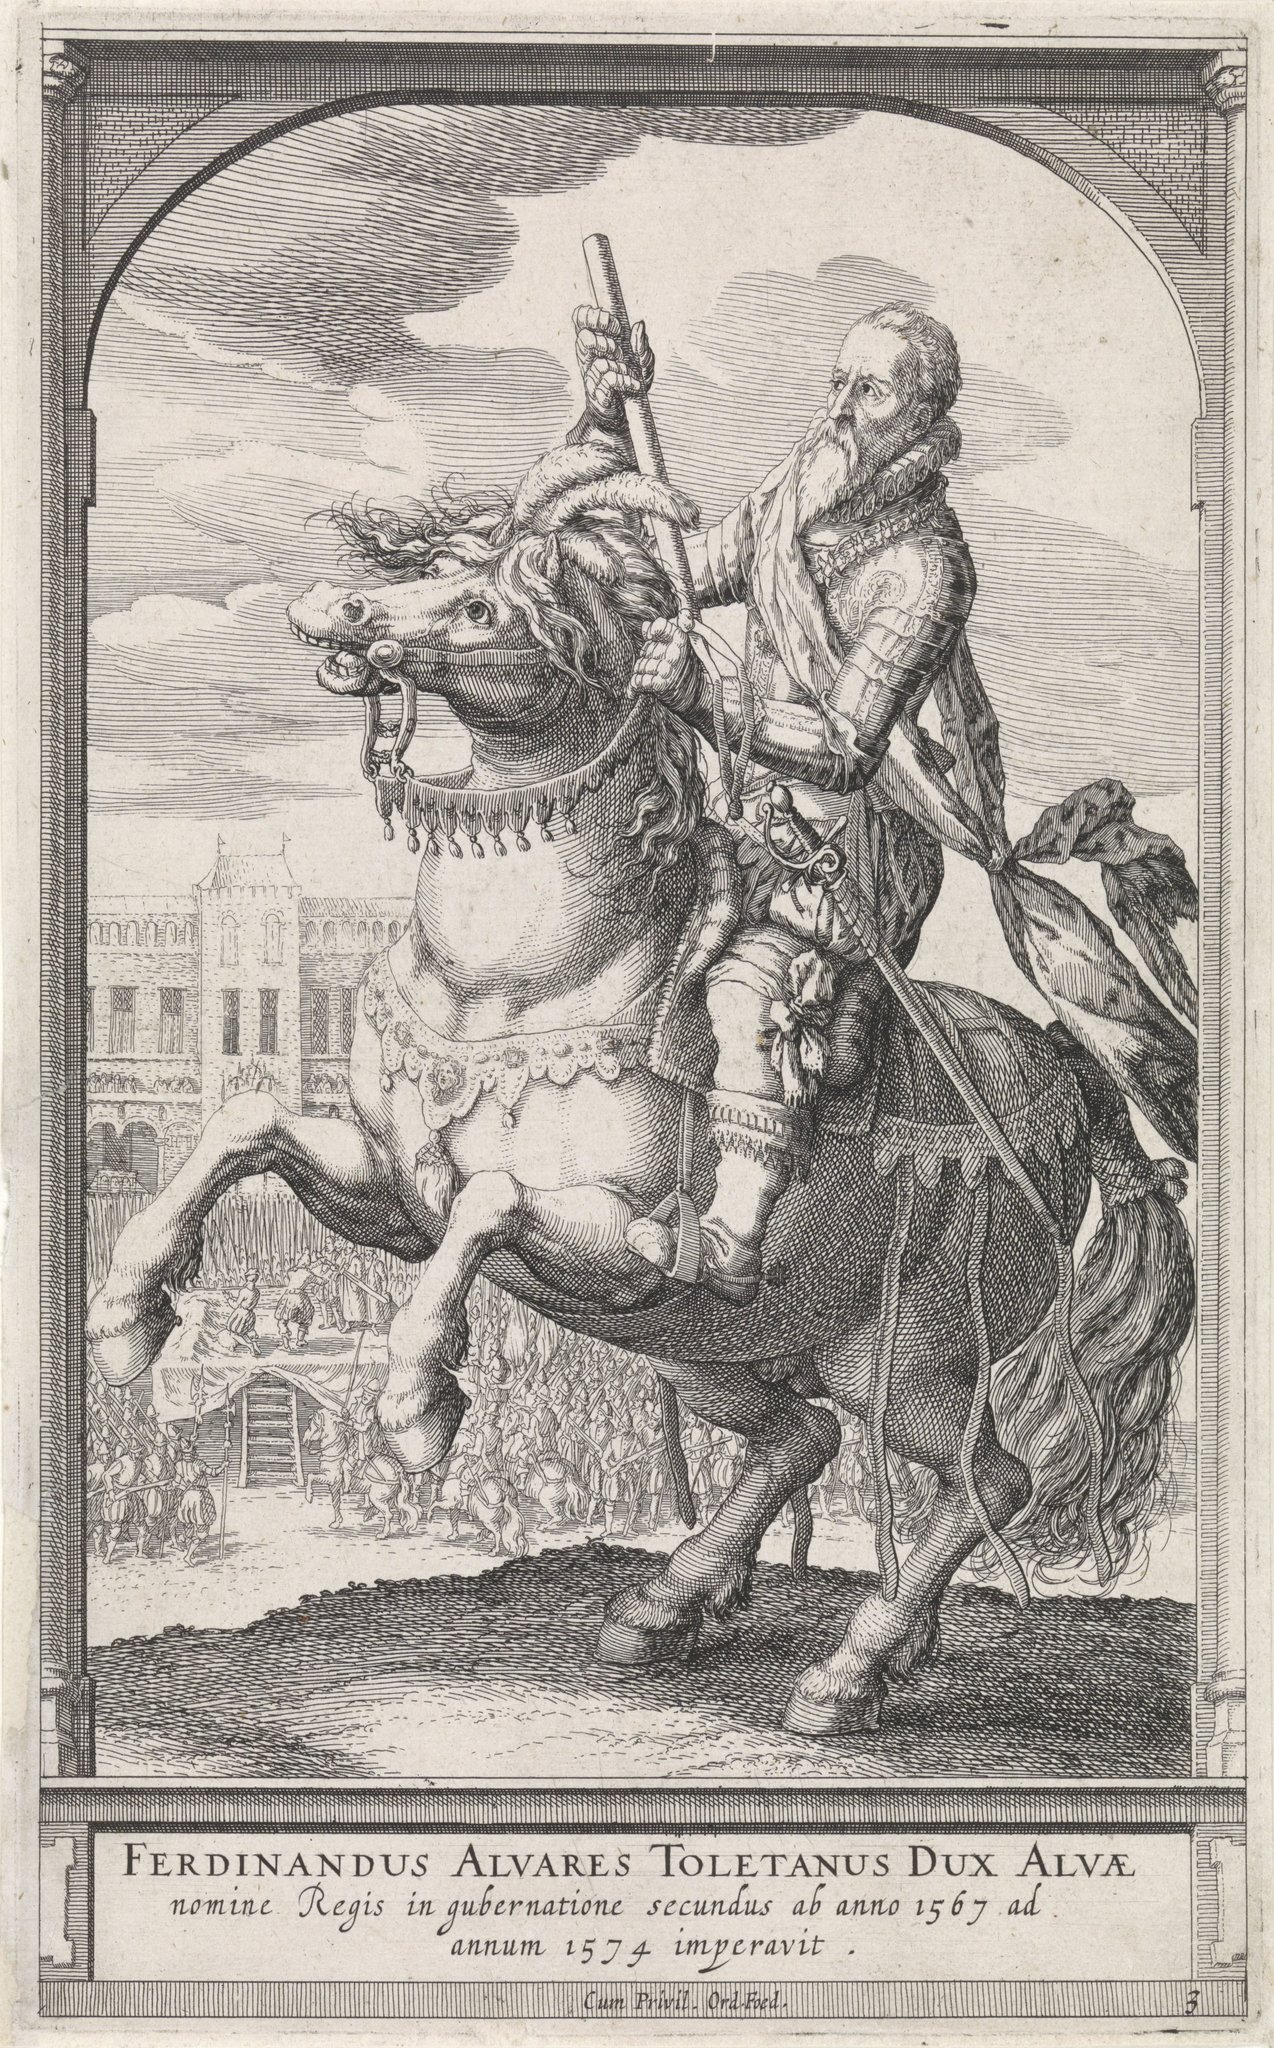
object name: print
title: Landvoogden van de Nederlanden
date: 1591-1632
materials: paper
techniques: etching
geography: amsterdam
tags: fernando álvarez de toledo (3rd duke of alba), riding a horse, ass, or mule; rider, horseman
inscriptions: collector's mark: Lugt 2228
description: De hertog van Alva, landvoogd van de Nederlanden te paard. Naar links. Hij heeft een staf in de hand. Op de achtergrond de executie van de graven van Egmond en Horne. De prent heeft een Latijns onderschrift en maakt deel uit van een serie ruiterportretten van Nederlandse landvoogden.